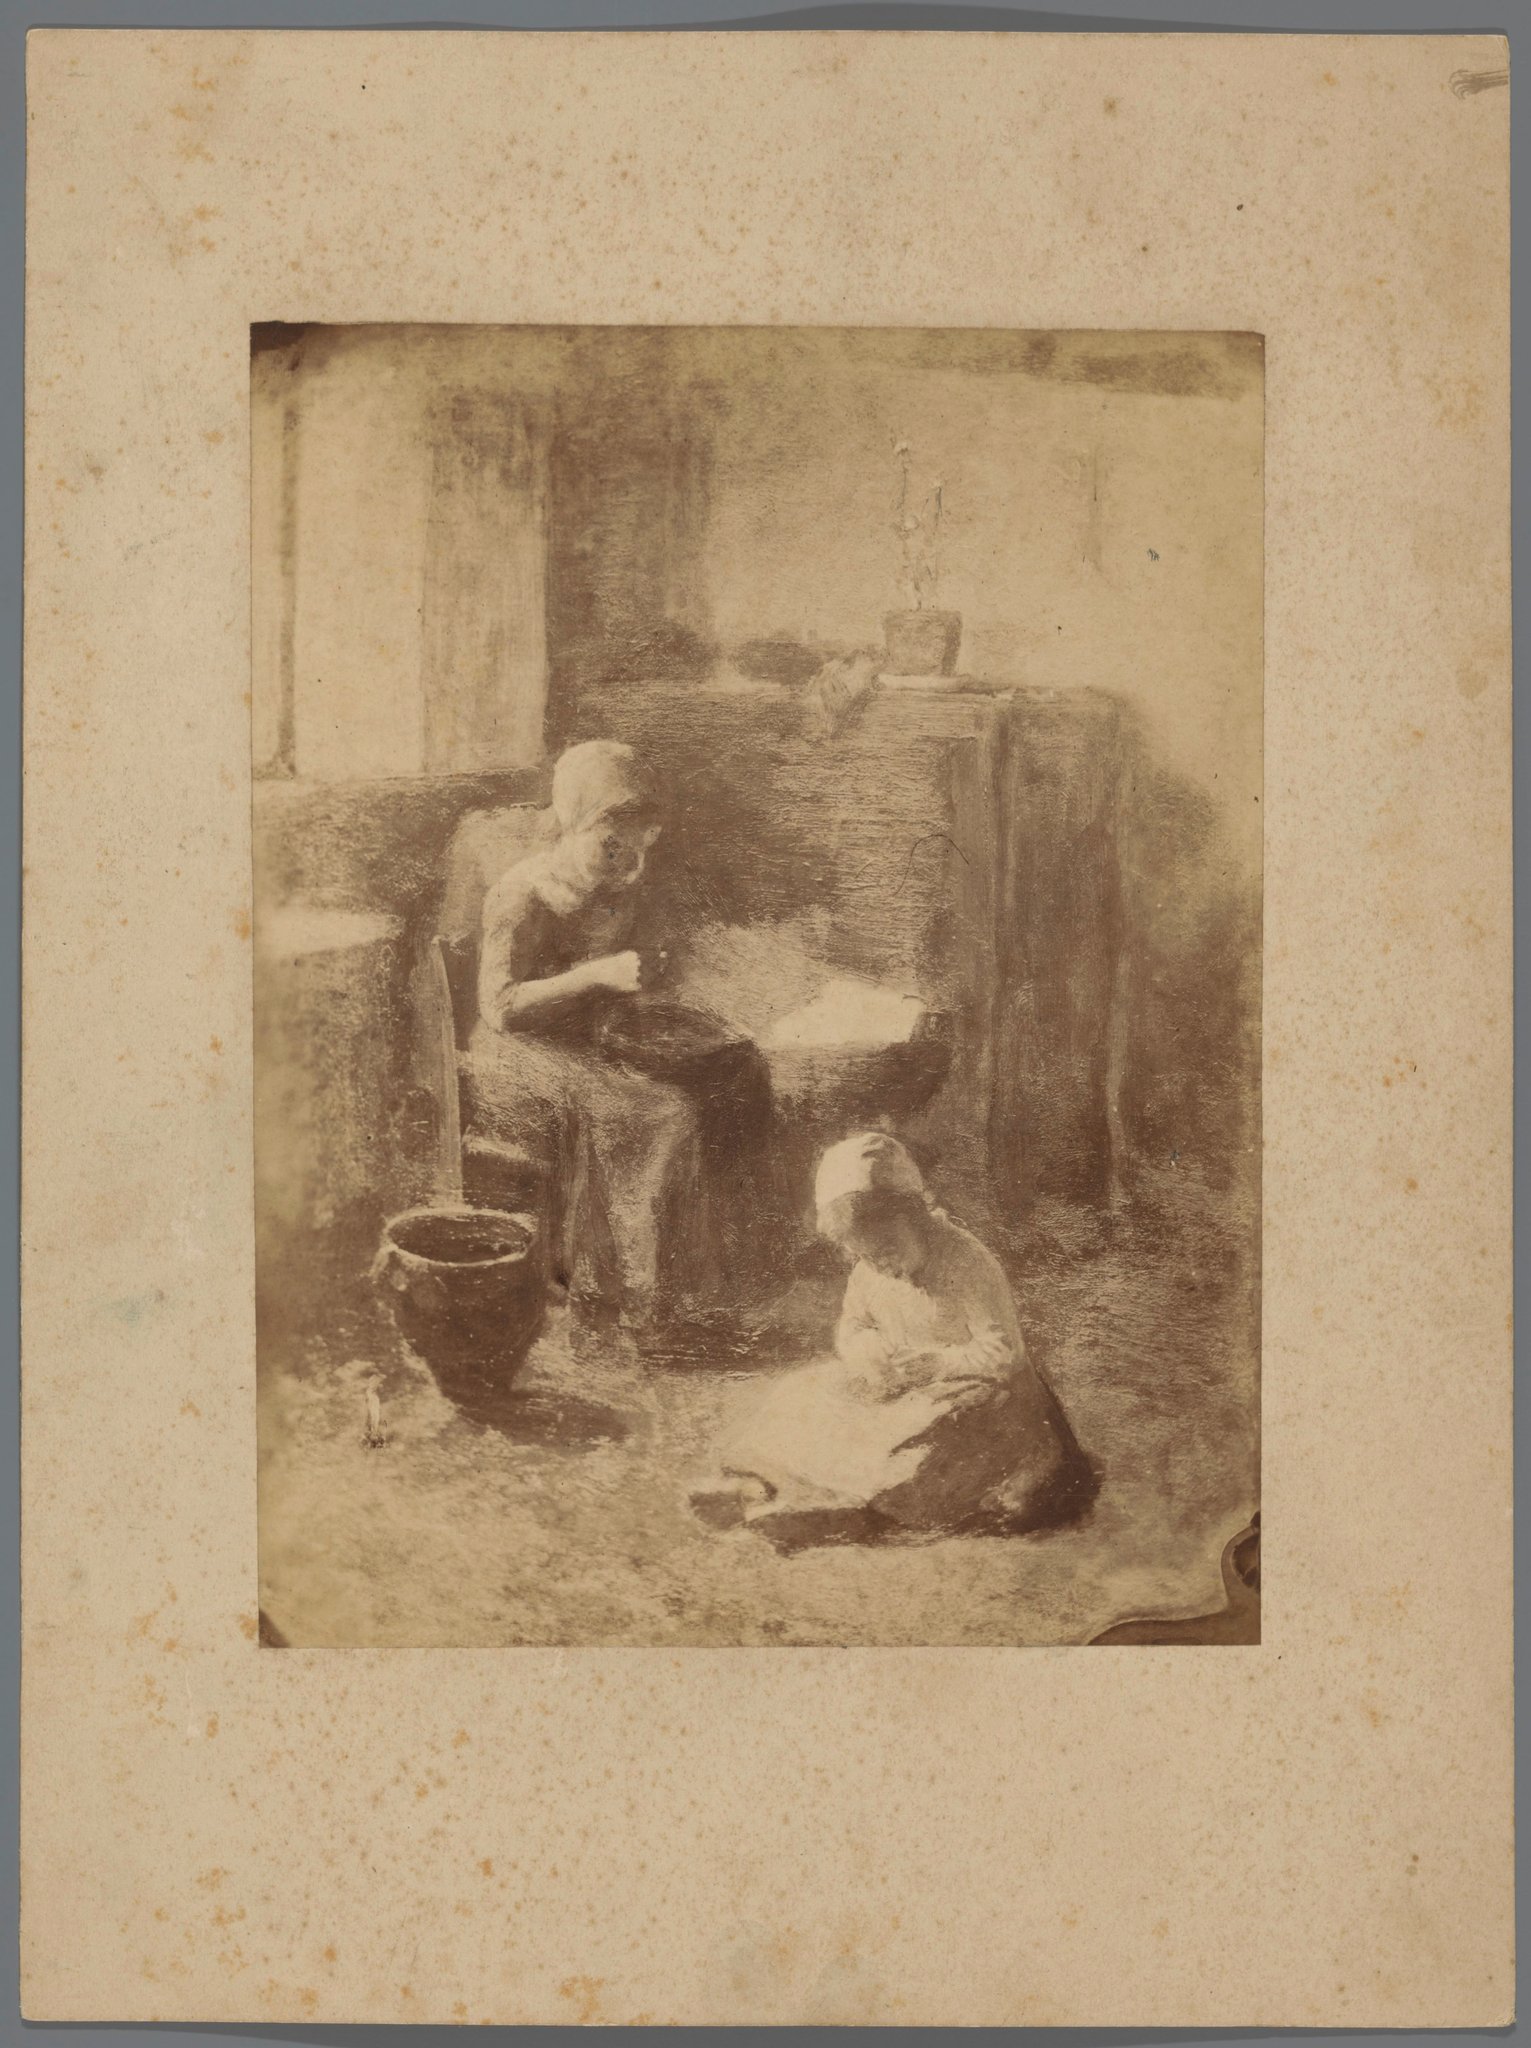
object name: photograph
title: Fotoreproductie van schilderij door Albert Neuhuys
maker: Anonymous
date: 1850-1900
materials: cardboard, photographic support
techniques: albumen print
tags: child, interior of the house